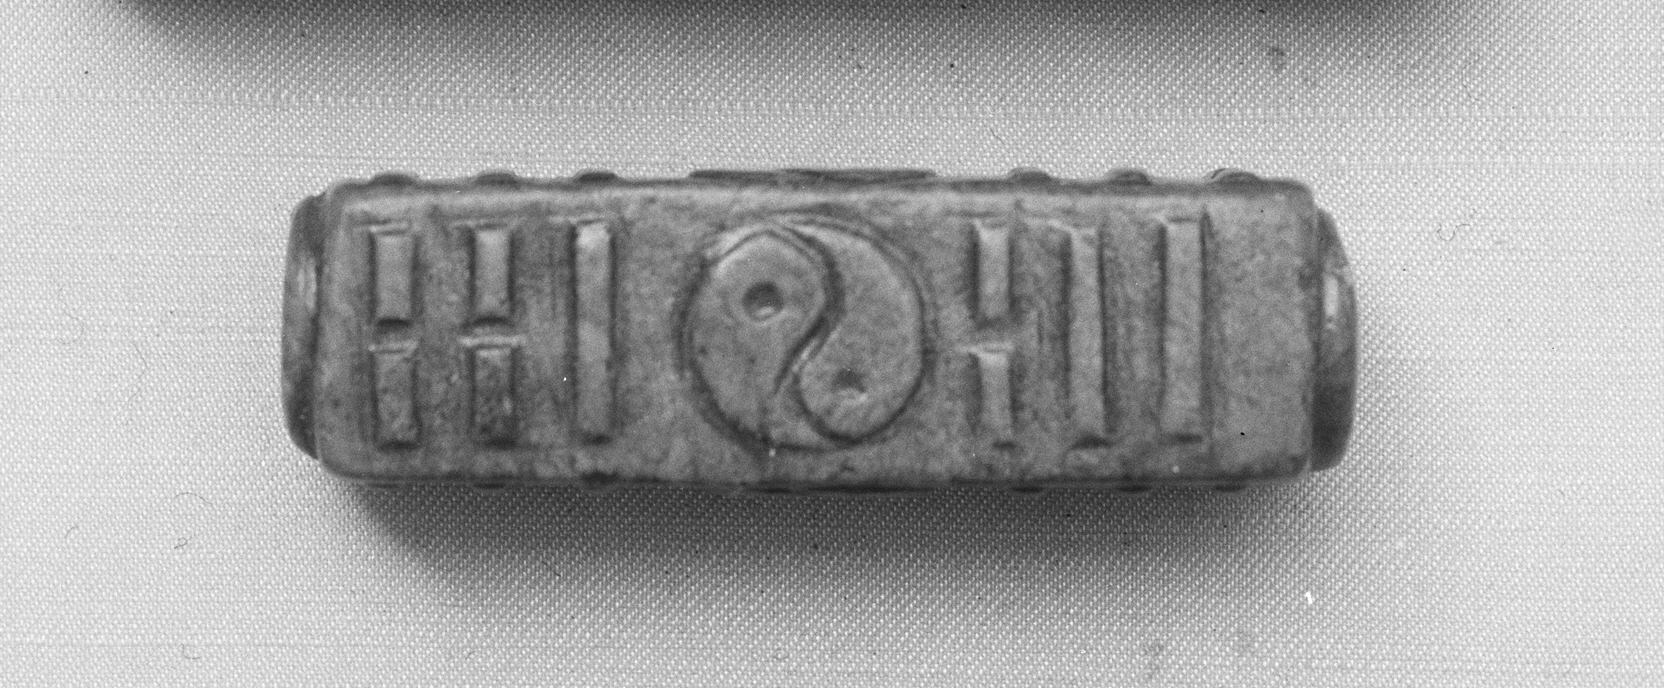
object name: bead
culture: chinese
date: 206 BCE-220 CE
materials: jade